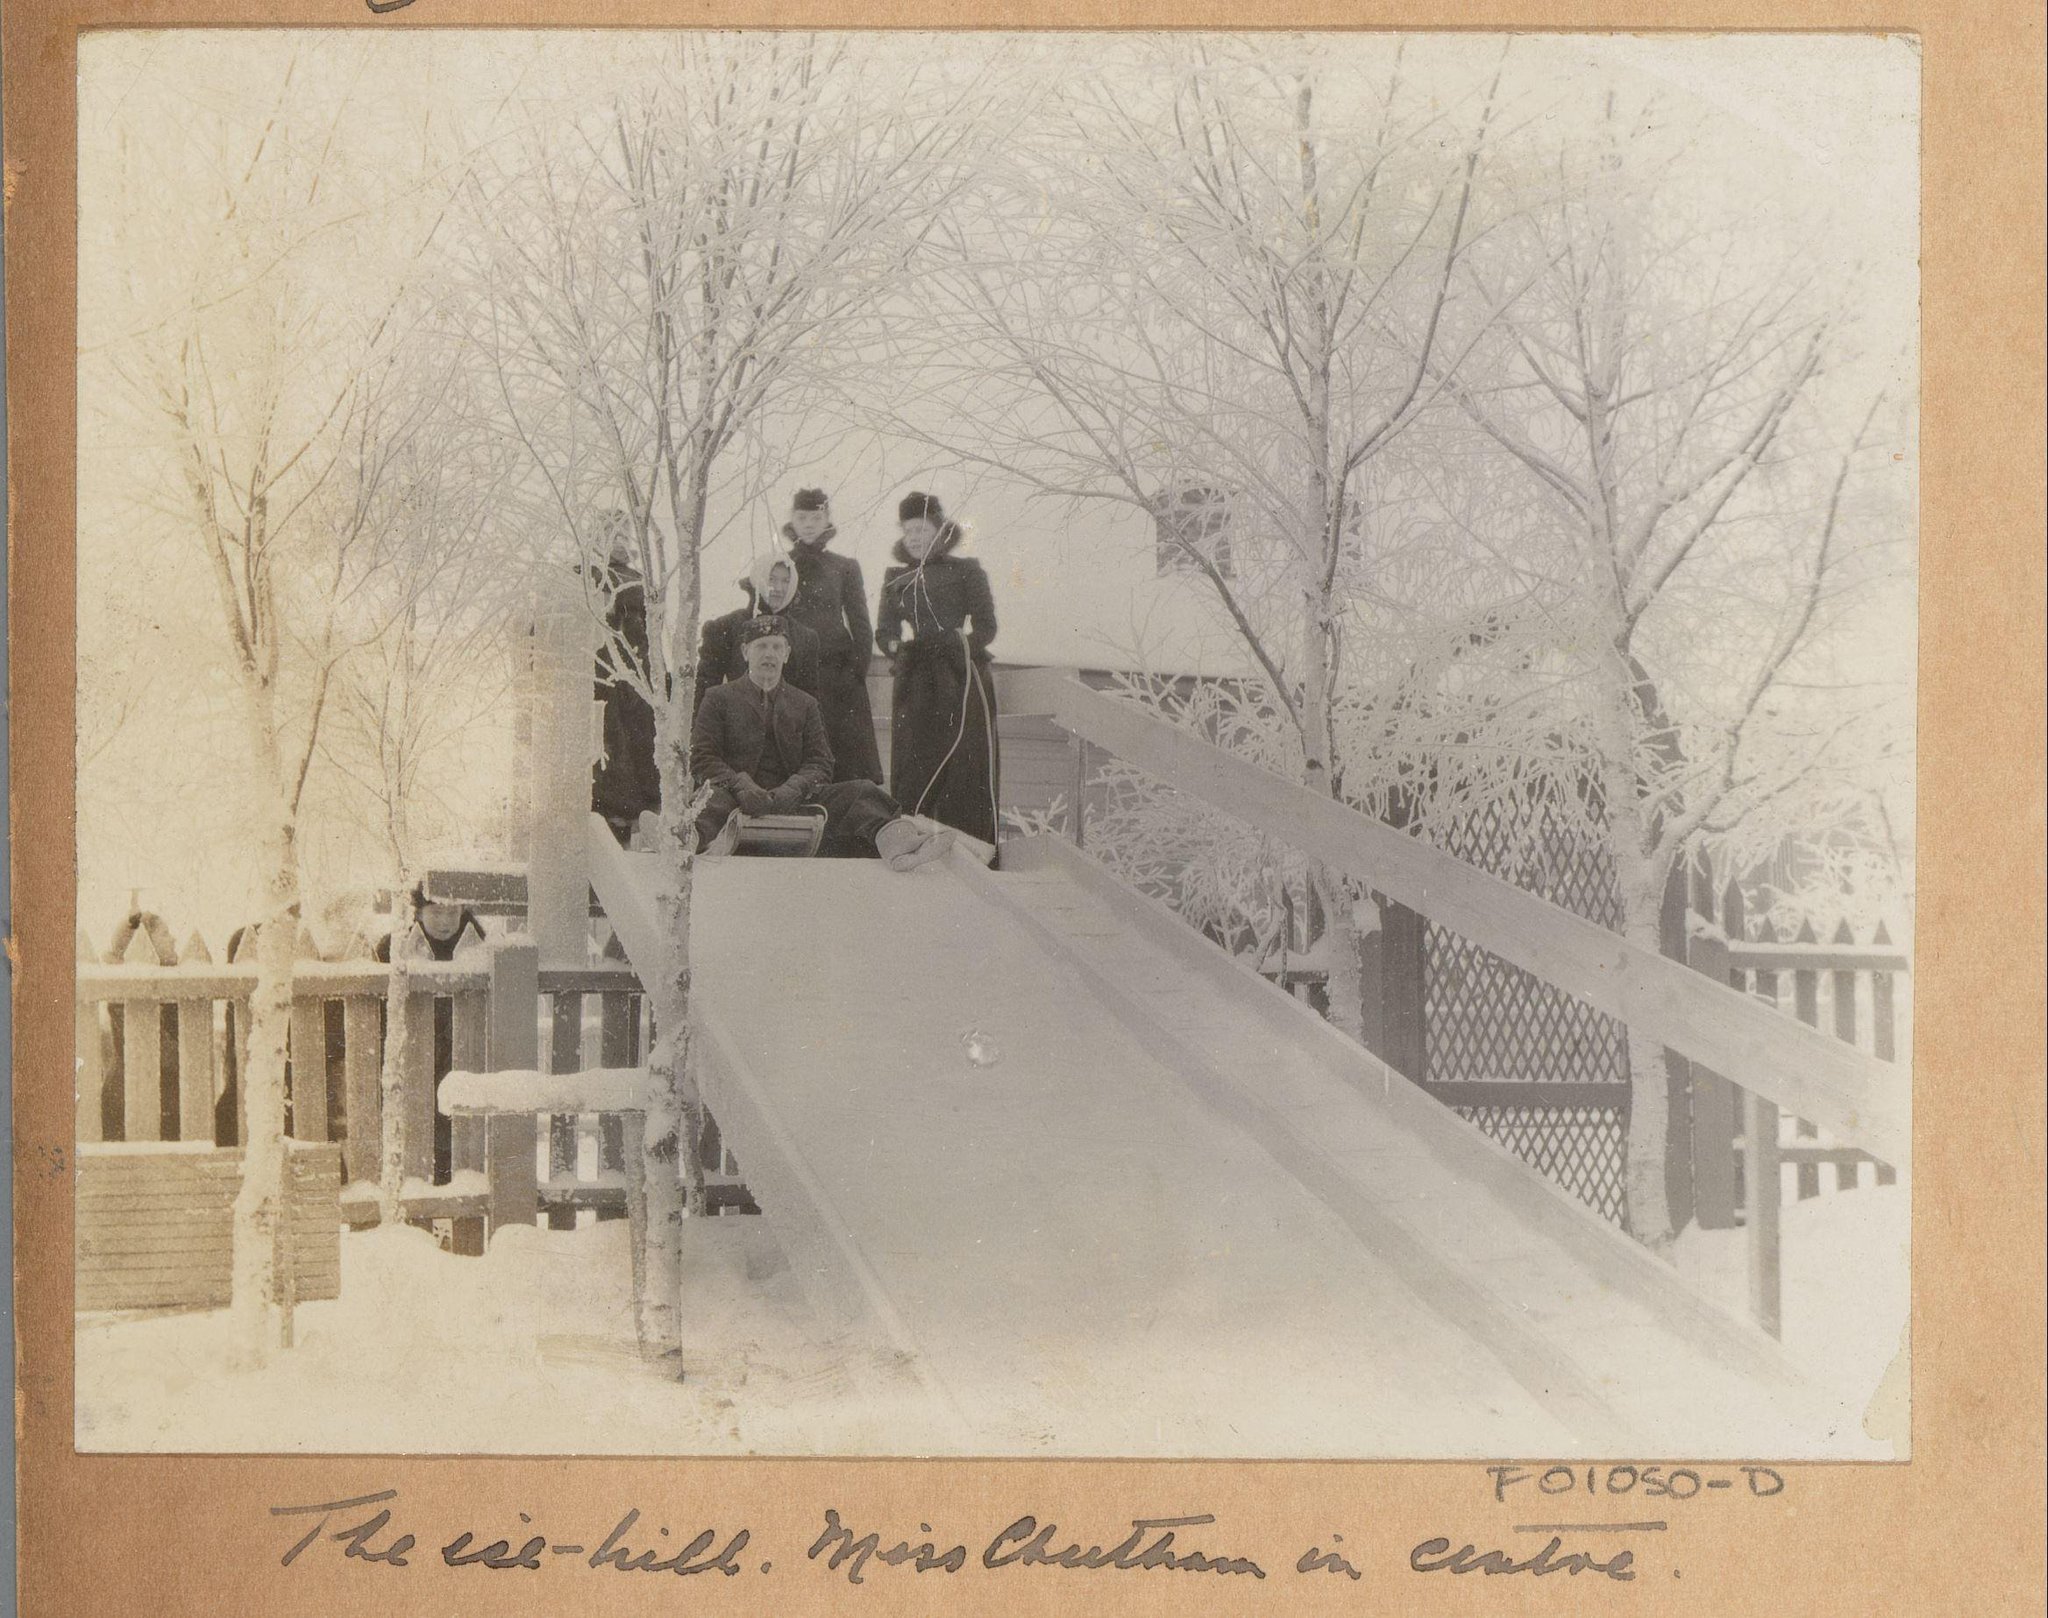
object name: photograph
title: Gezelschap rondom een slee op een glijbaan in Rusland, in het midden miss Cheetham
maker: joseph cheetham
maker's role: engineer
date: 1903-1904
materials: photographic support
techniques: gelatin silver print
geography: russia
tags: snow, small sleigh (winter sports), russia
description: Onderdeel van Fotoalbum van de Engelse familie Cheetham met opnames van hun verblijf in Rusland.